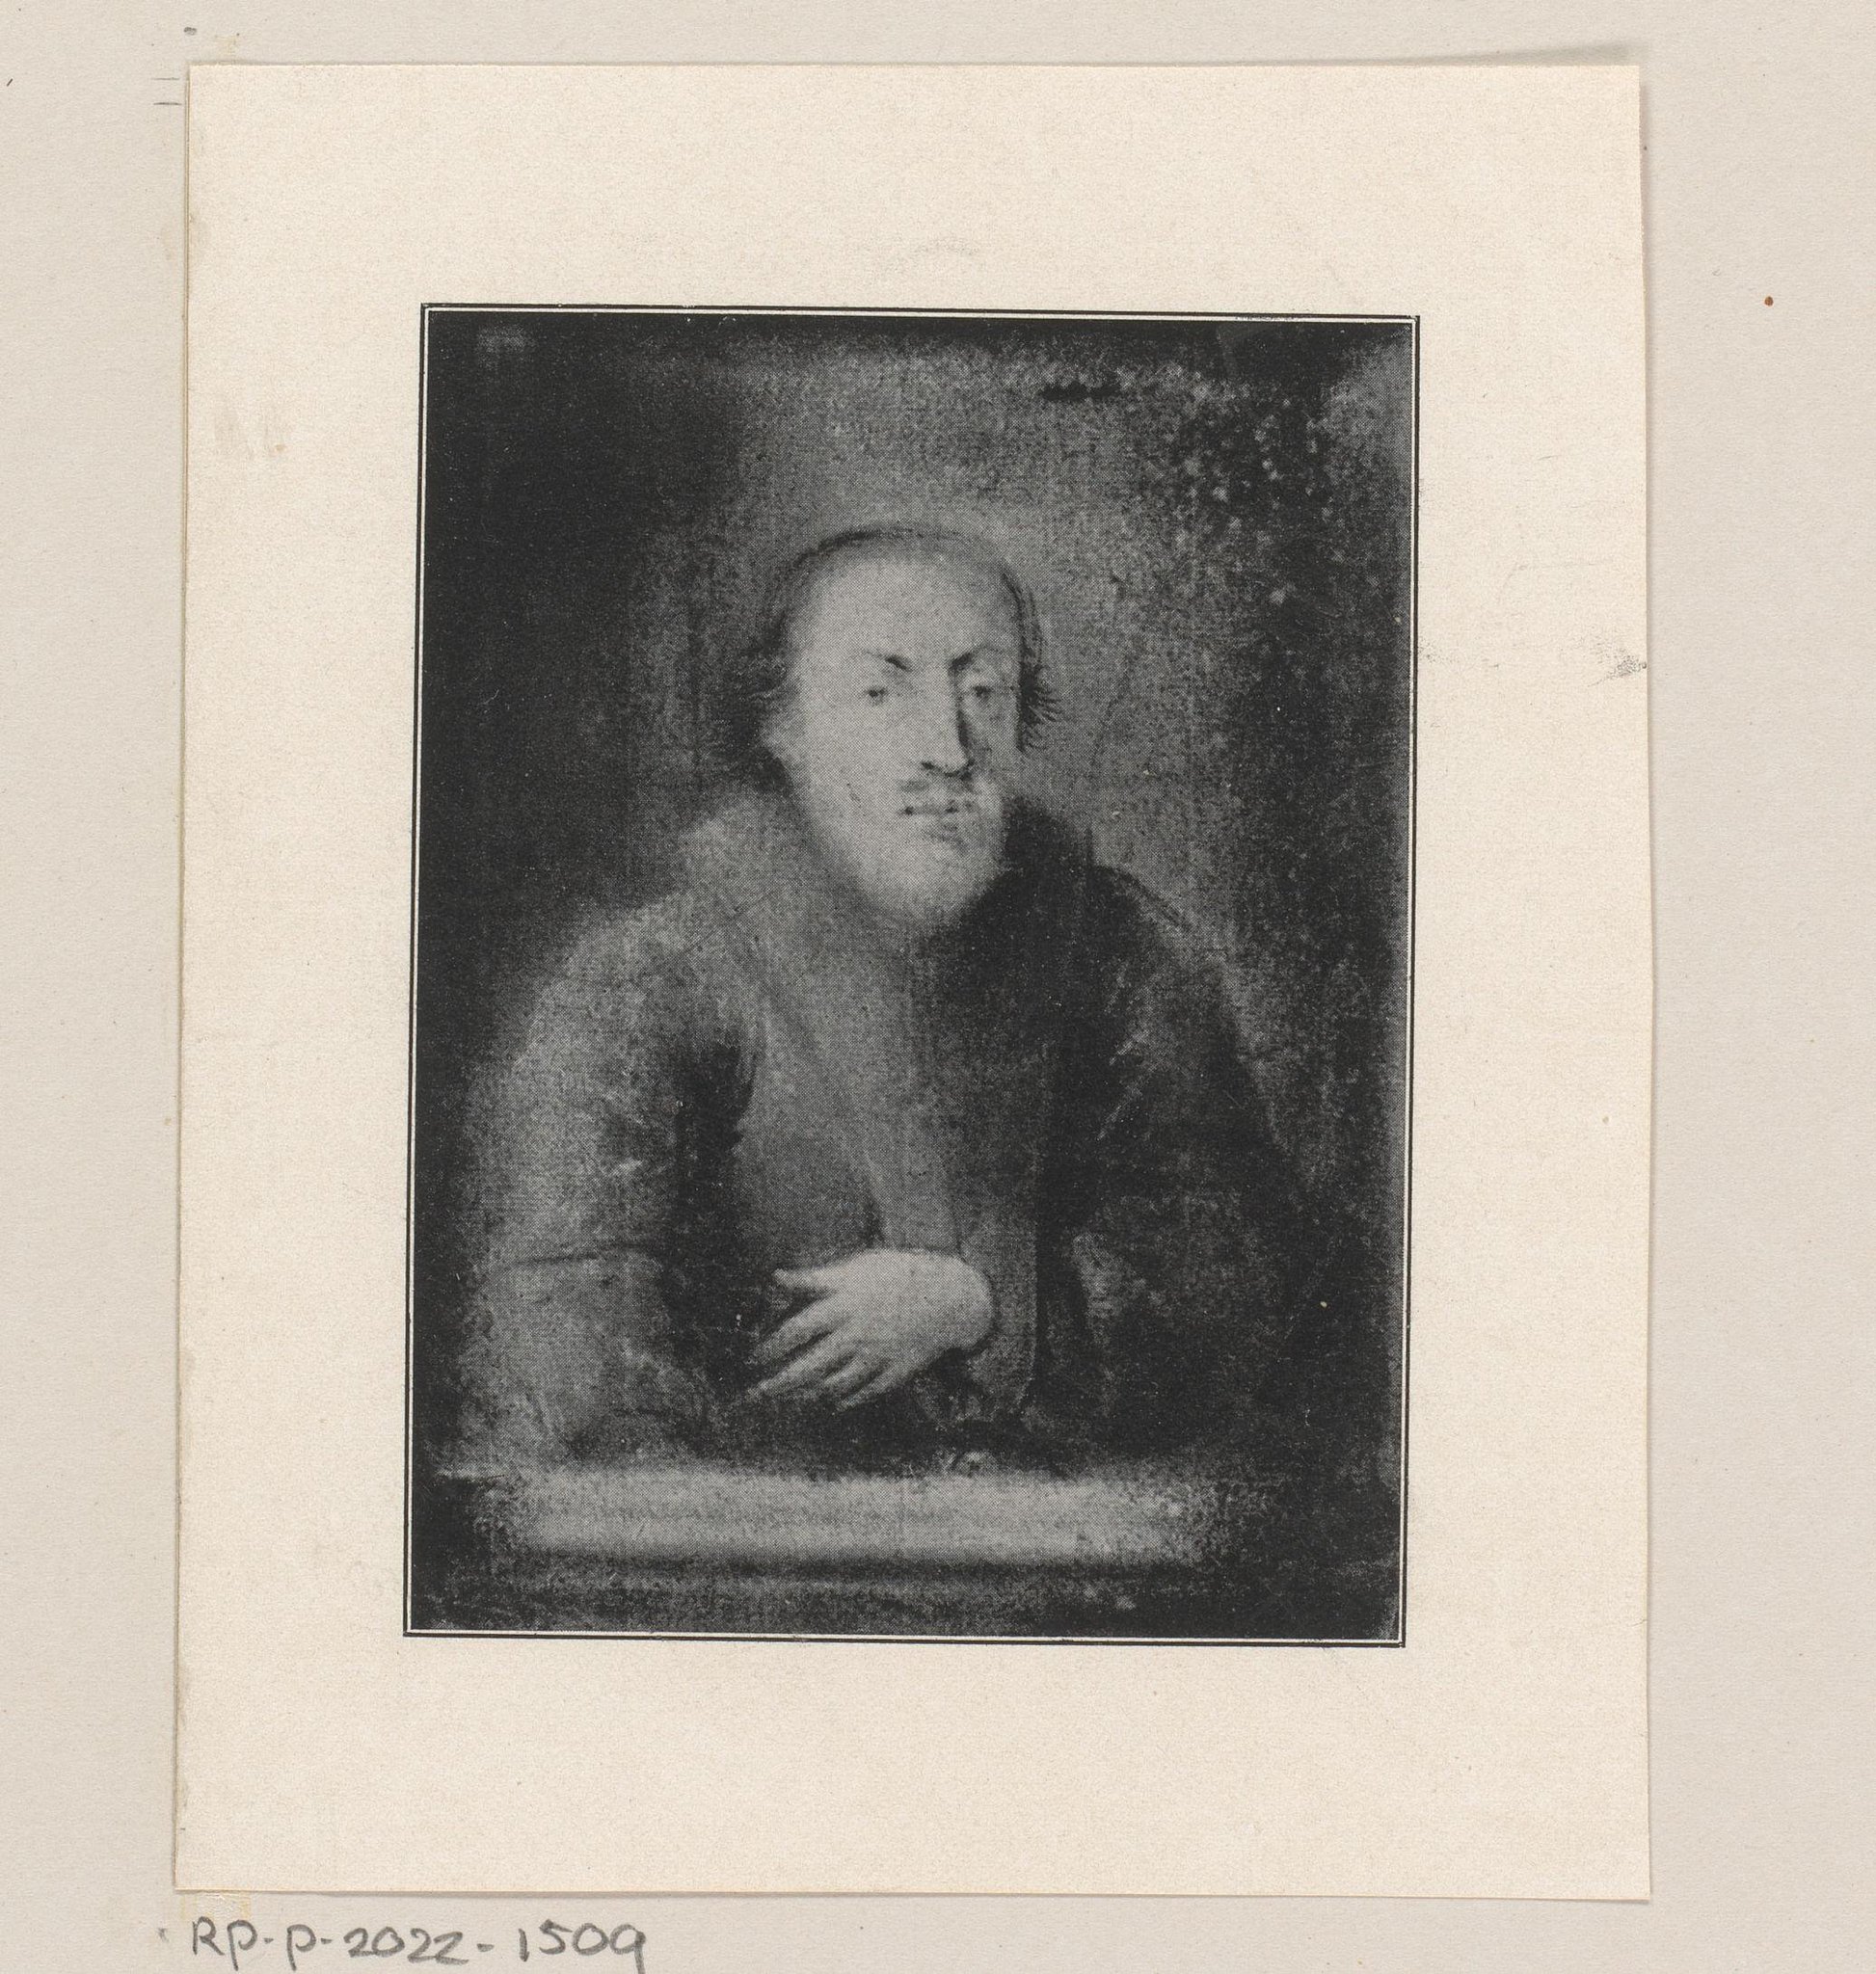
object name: photomechanical print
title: Portret van Jacob Frederik Muller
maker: Anonymous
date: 1882-1970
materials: paper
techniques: autotype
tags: historical persons, criminals